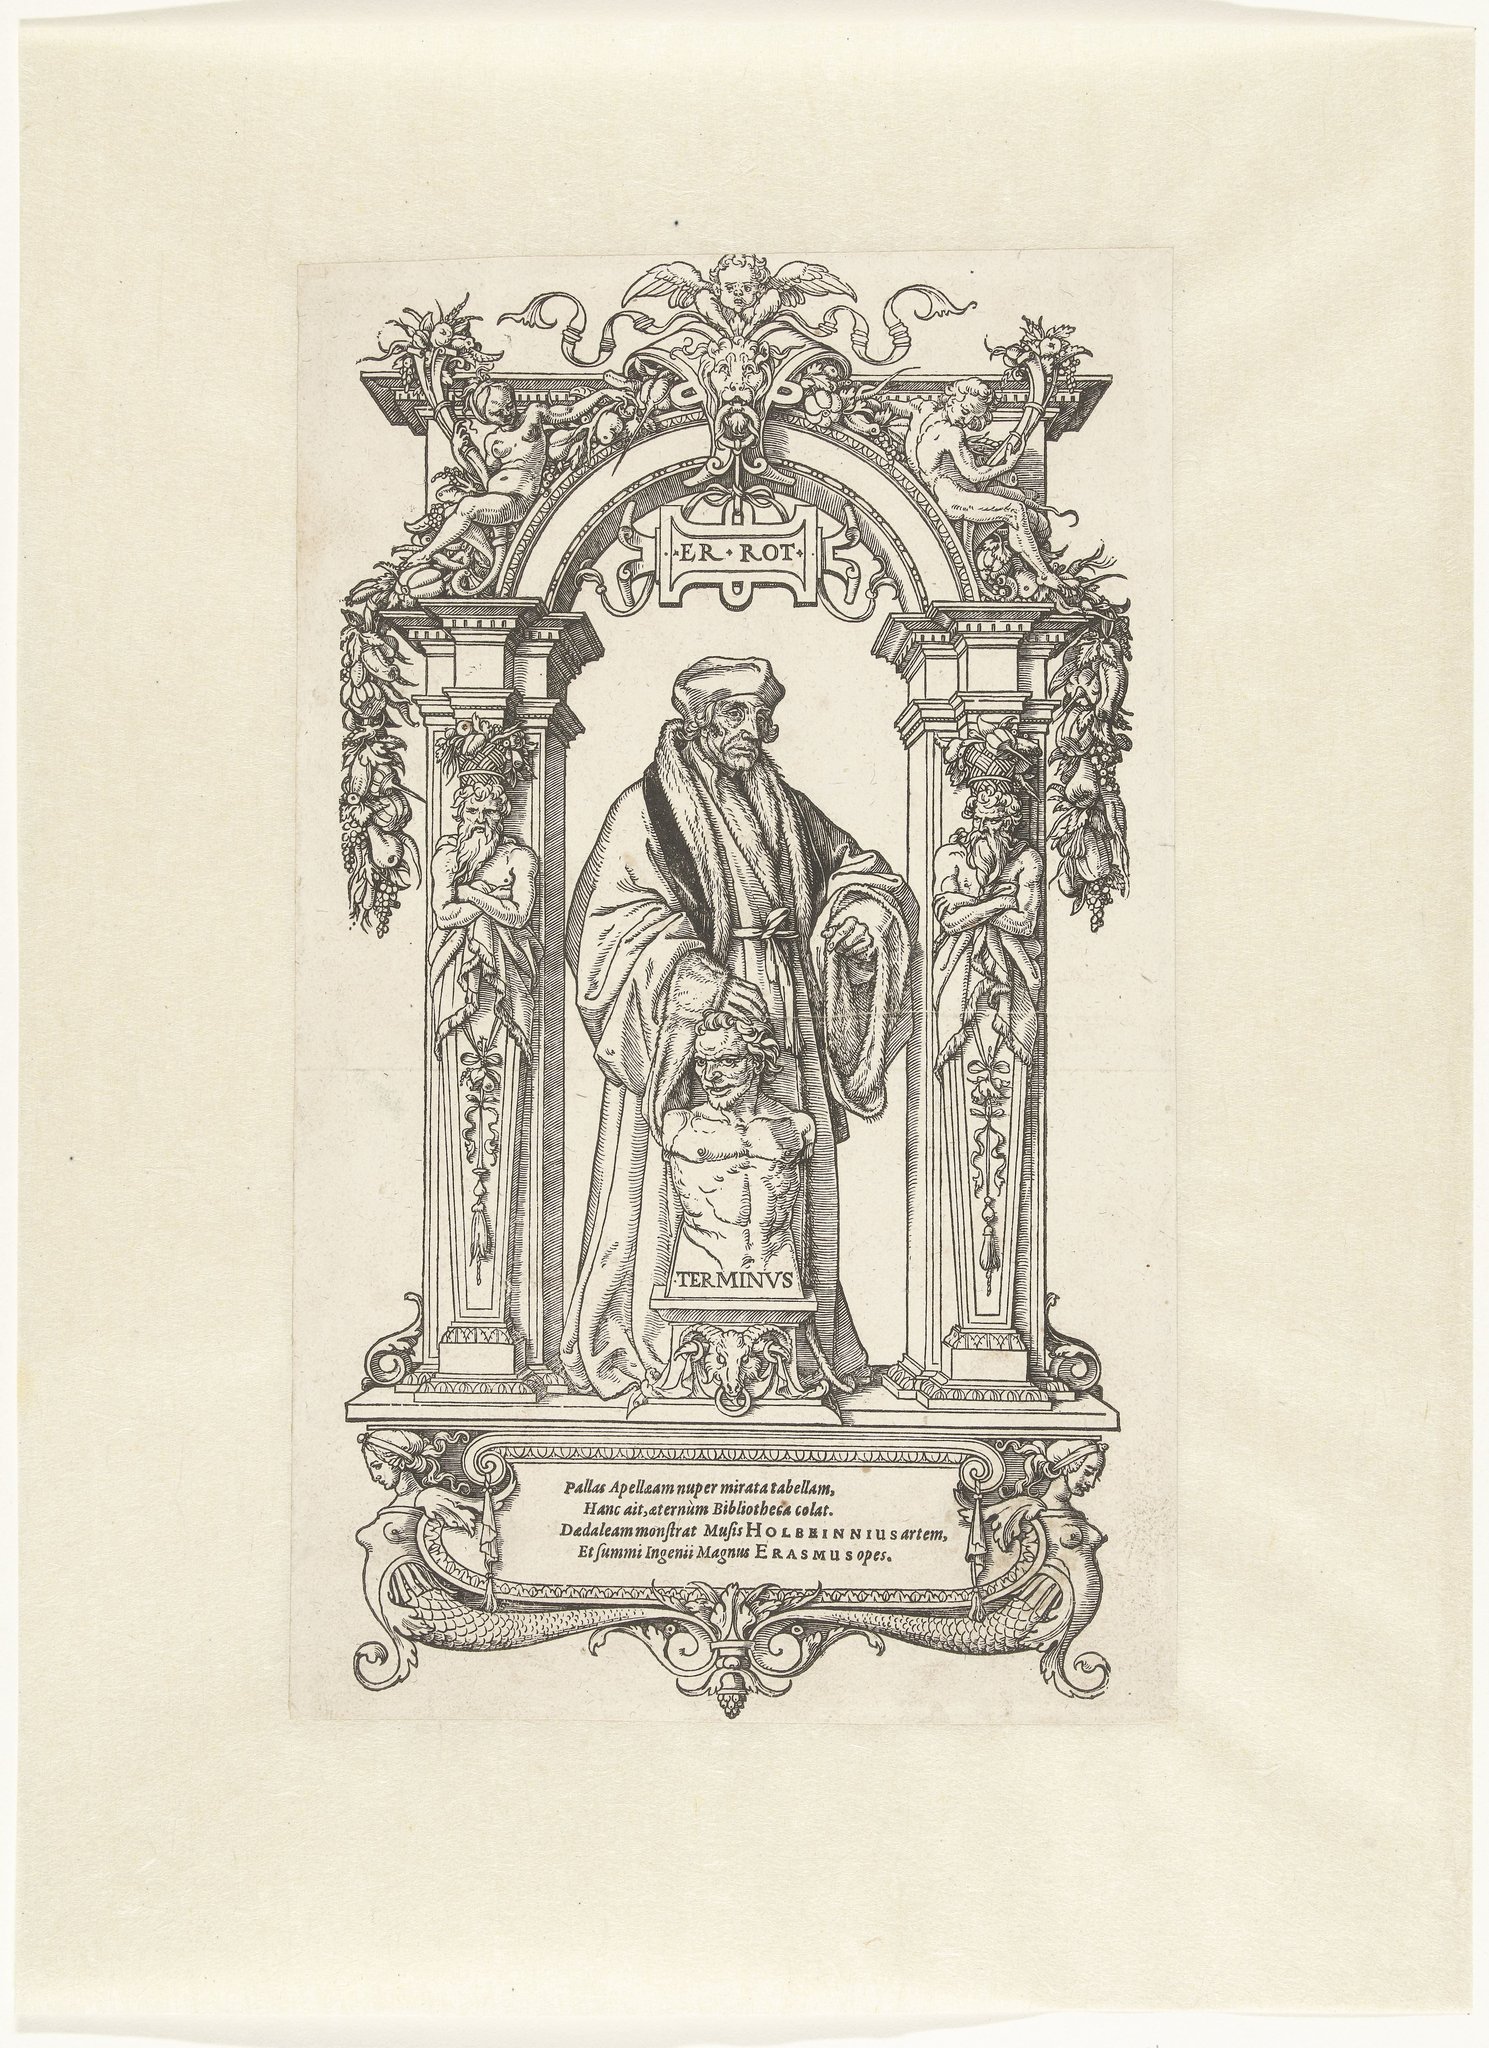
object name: print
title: Portret van Erasmus staand onder boog met beeld van Terminus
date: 1536-1540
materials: paper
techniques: woodcut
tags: rotterdam, desiderius erasmus, ornaments ~ art, terminus, arch, archivolt ~ architecture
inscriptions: collector's mark: ‘A III/ Vom/ K. Kupferstichkabinet/ Berlin/ veräussert’, collector's mark: Lugt 2228a, collector's mark: Lugt 2922, collector's mark: Lugt 1606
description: Portret van Erasmus staand onder een boog, met zijn hand rustend op een beeld van Terminus. De boog in renaissance architectuur is rijk versierd met ornamenten. In een cartouche onder de boog staan vier regels Latijnse tekst: Pallas Apellaeam nuper ... Magnus ERASMUS opes.